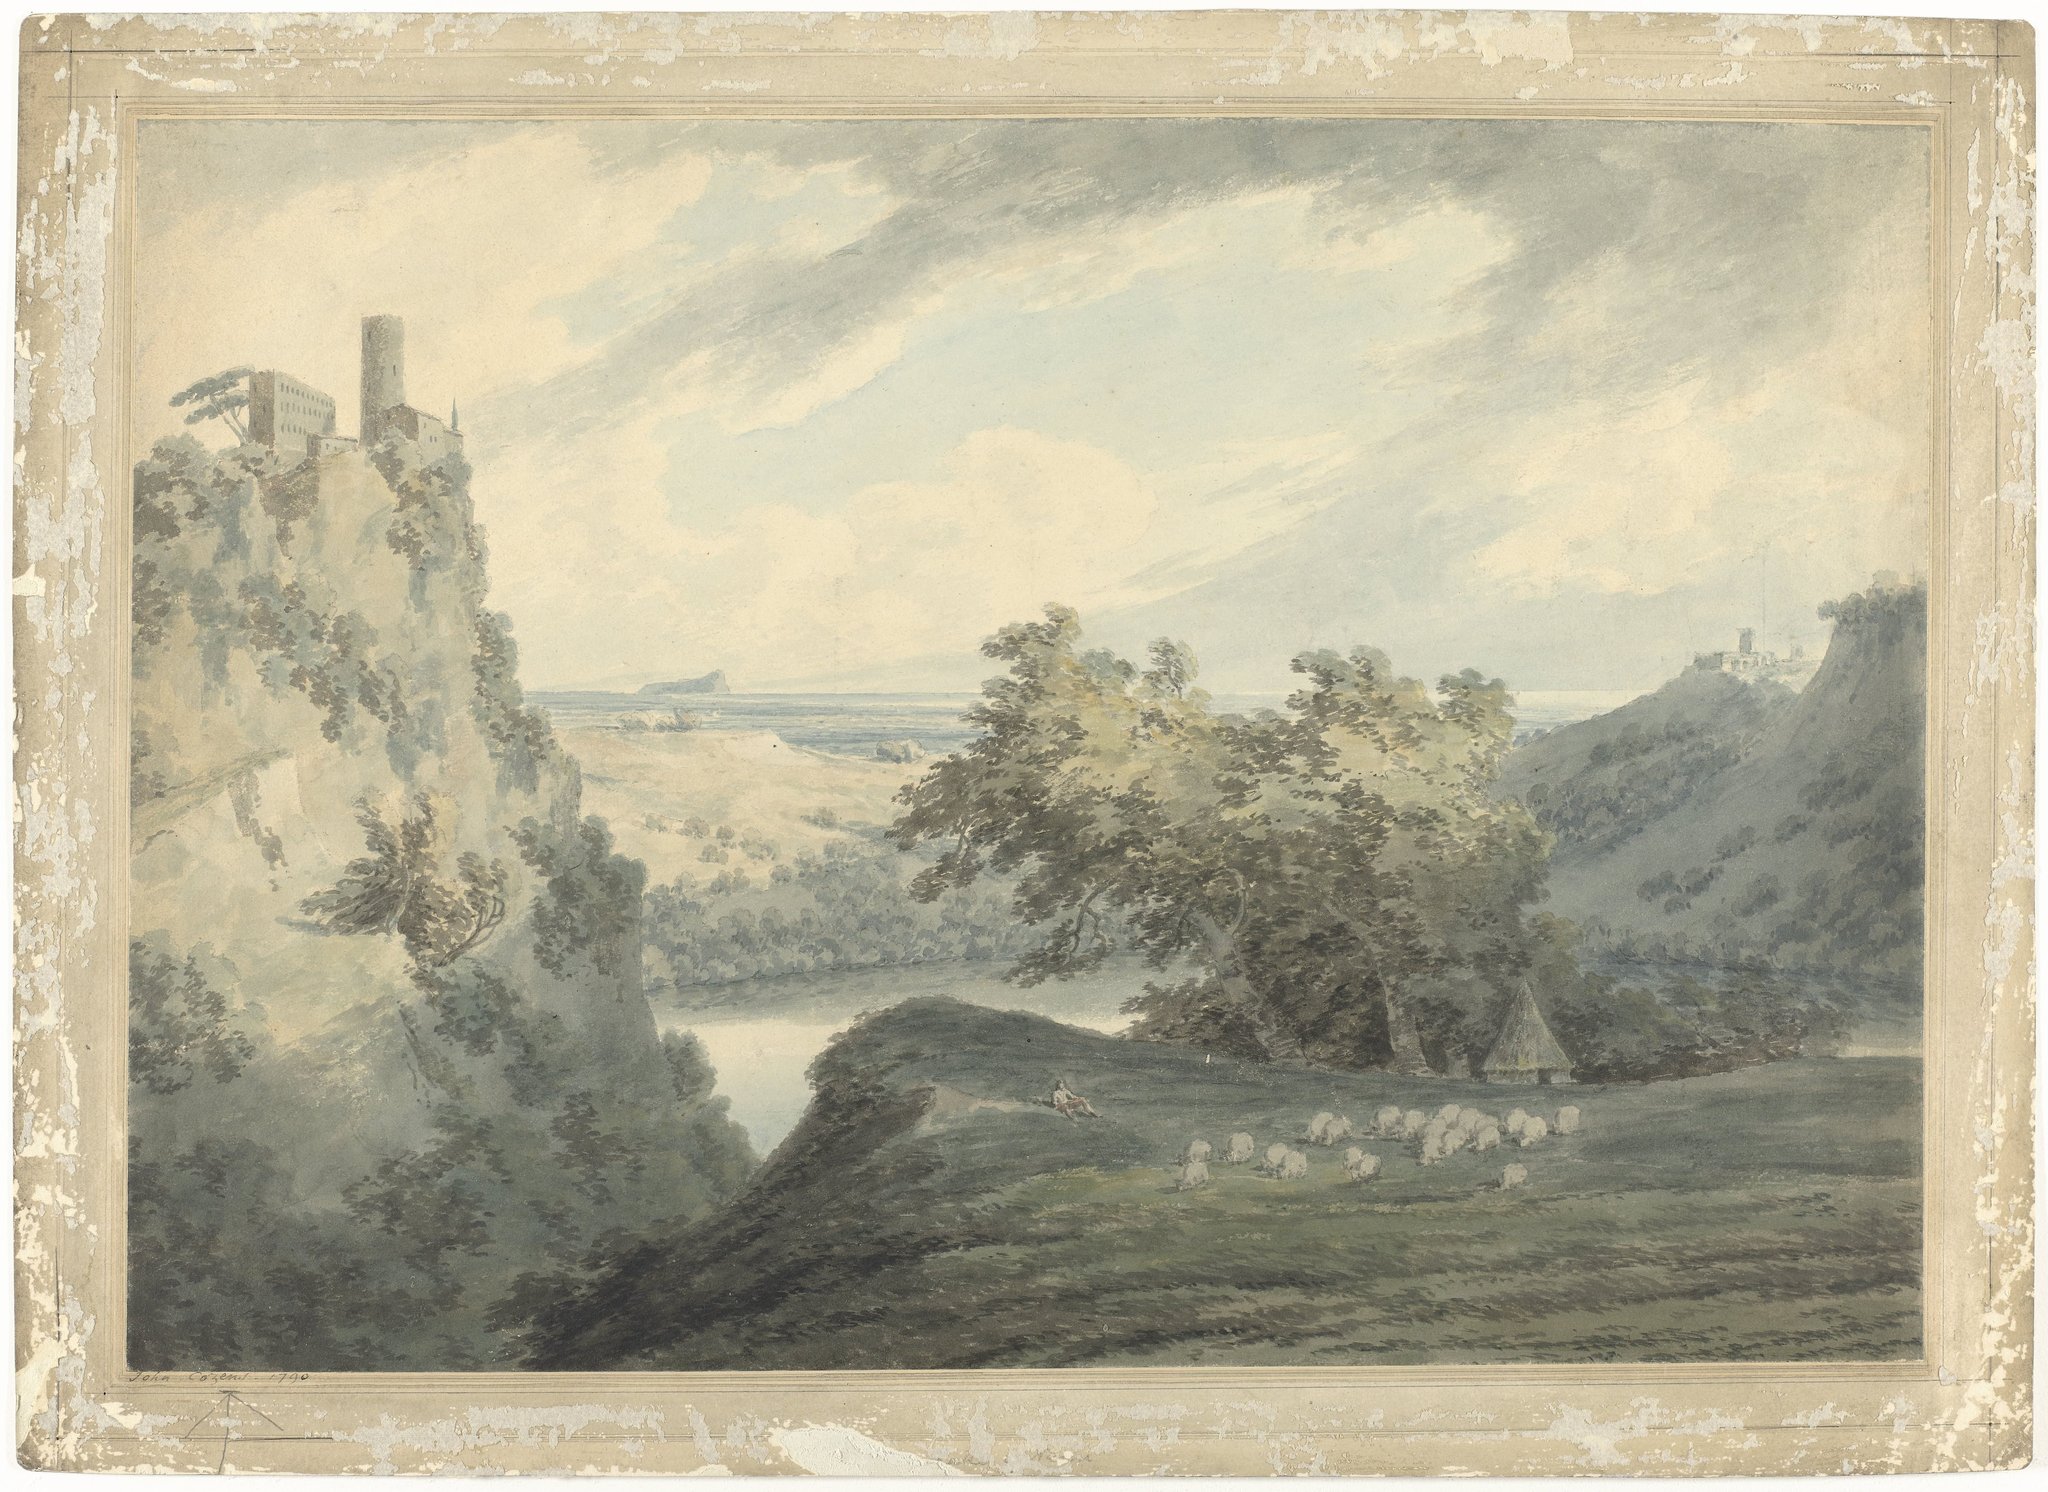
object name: drawing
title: Italian Mountainous Landscape with Lake Nemi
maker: john robert cozens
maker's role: draughtsman, print maker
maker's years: 1752-1797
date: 1790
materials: paper, pencil, watercolor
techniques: brush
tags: (high) hill, lake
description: John Robert Cozens sojourned twice in Italy for extended periods of time. He made many drawn studies there, on which he later based this water colour. Cozens wanted to paint sublime landscapes. This found expression not only in the depiction itself, but also in the muted, broad passages of wash, meant to lend the image a universal grandeur. Specific touches of bright colours, such as red, were used only for details.